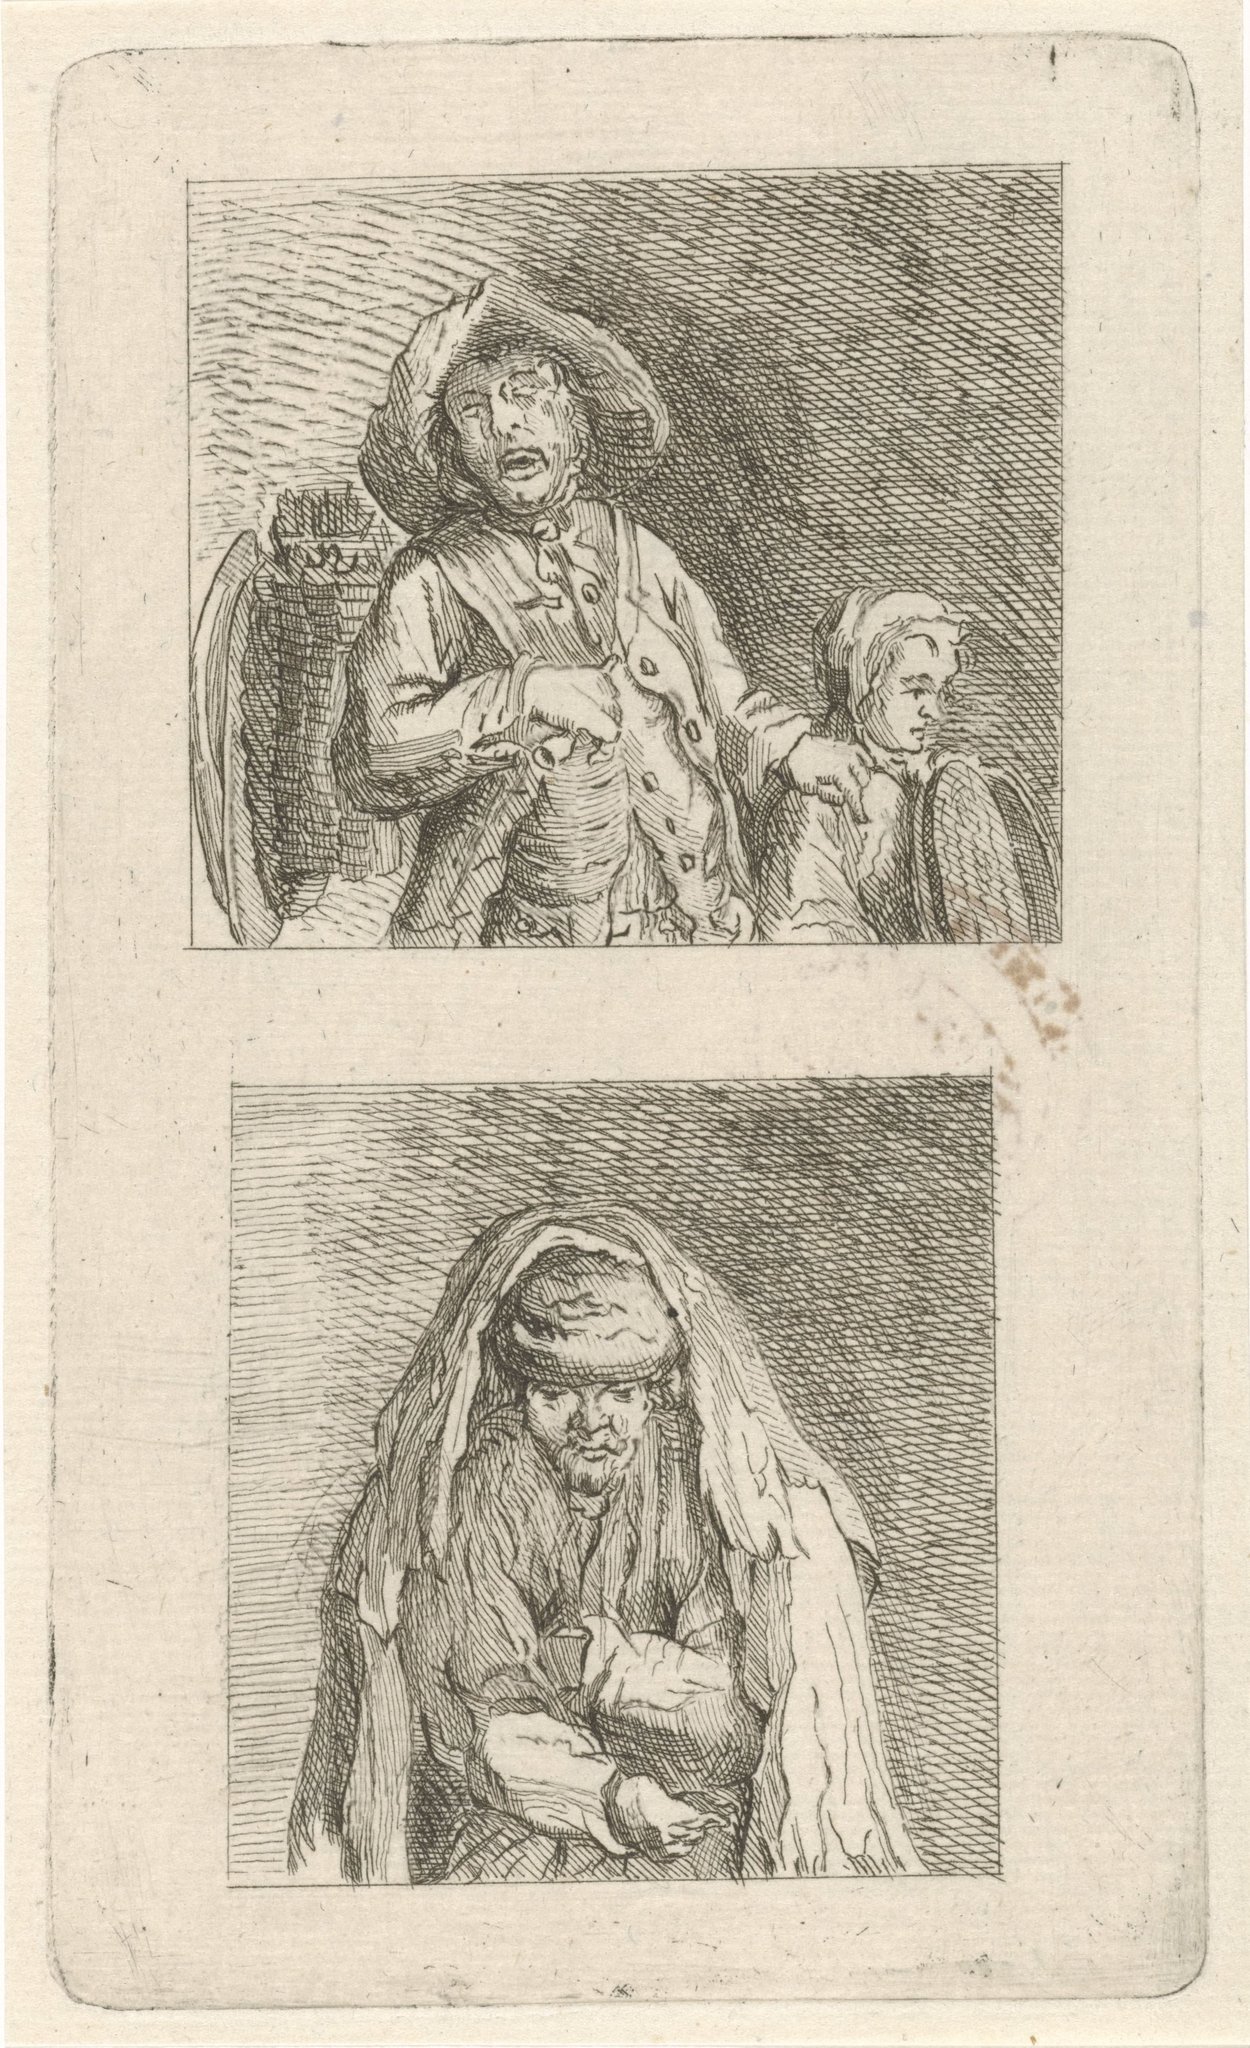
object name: print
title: Blinde met begeleider en bedelaar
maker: pieter de mare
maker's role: print maker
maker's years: 1758-1796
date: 1768-1796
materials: paper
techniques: etching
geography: leiden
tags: blind, blindness, beggar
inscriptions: collector's mark: Lugt 240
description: Twee voorstellingen; boven een een blinde met een begeleider en onder een bedelaar in lompen.